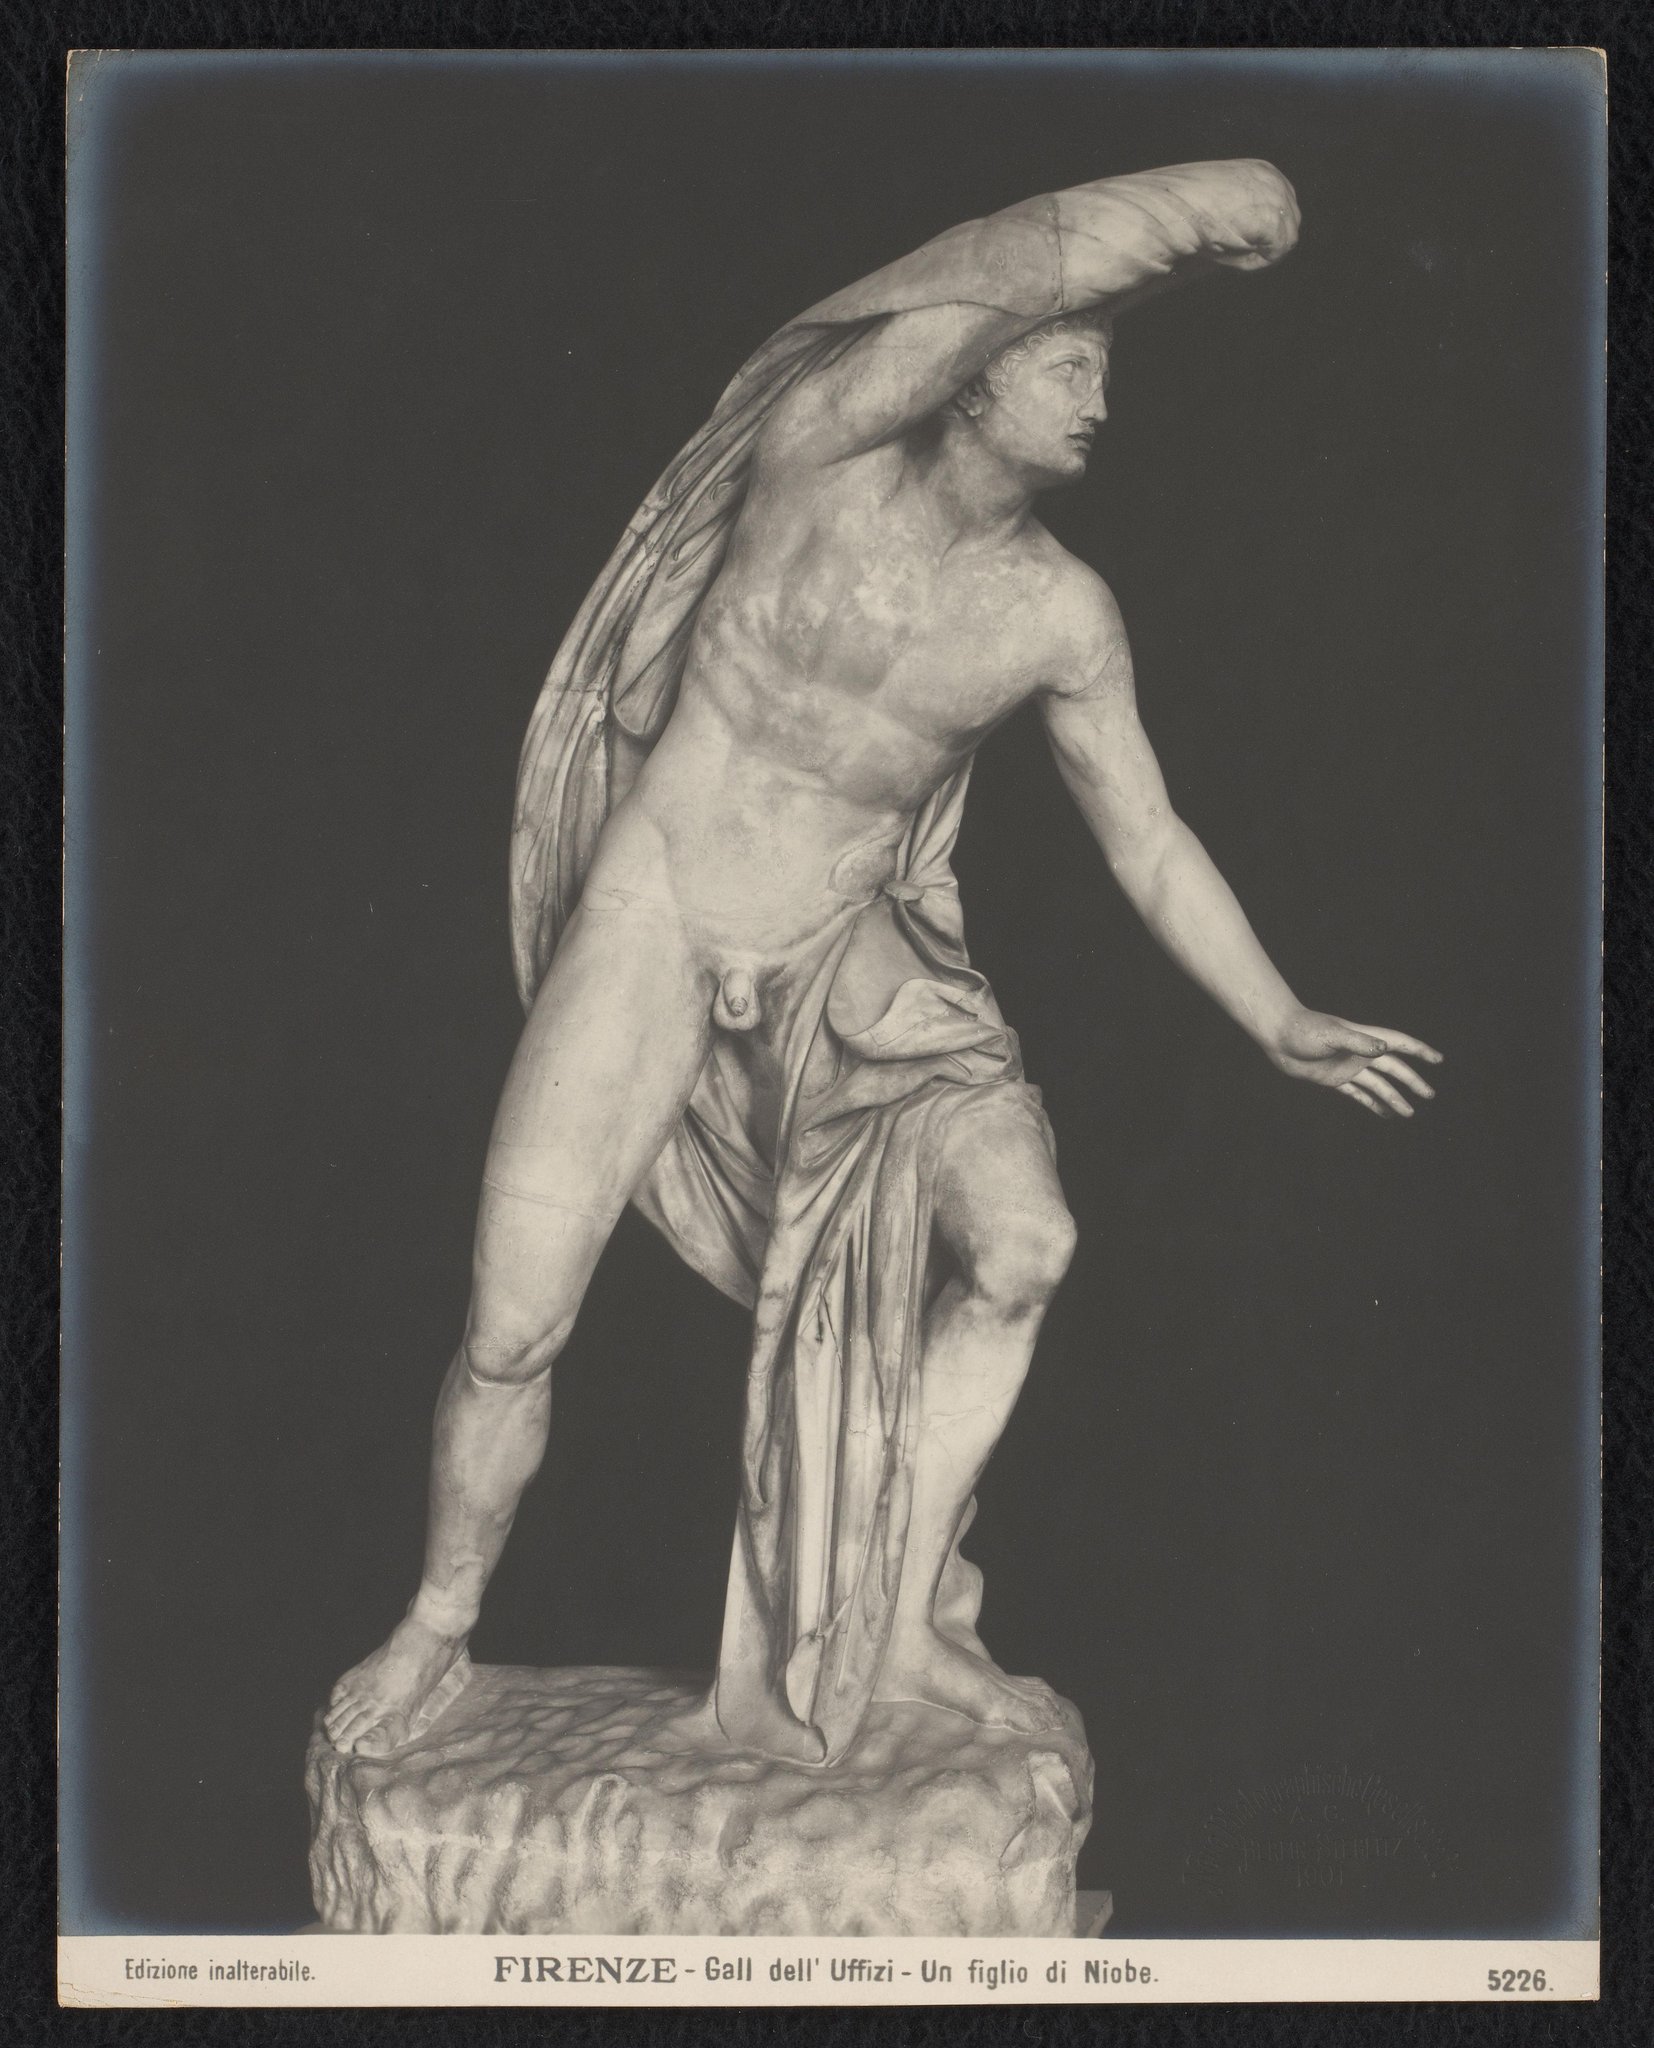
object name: photograph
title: Firenze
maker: Anonymous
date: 1901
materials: paper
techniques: gelatin silver print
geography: berlin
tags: (story of) bacchus (dionysus), liber, piece of sculpture, reproduction of a piece of sculpture, (story of) niobe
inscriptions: number: ‘5226.’, inscription: ‘Edizione inalterabile.’, collector's mark: ‘RIJKS SCHOOL VOOR KUNSTNIJVERHEID/ GROEP’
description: Deze foto maakt deel uit van een omslag.